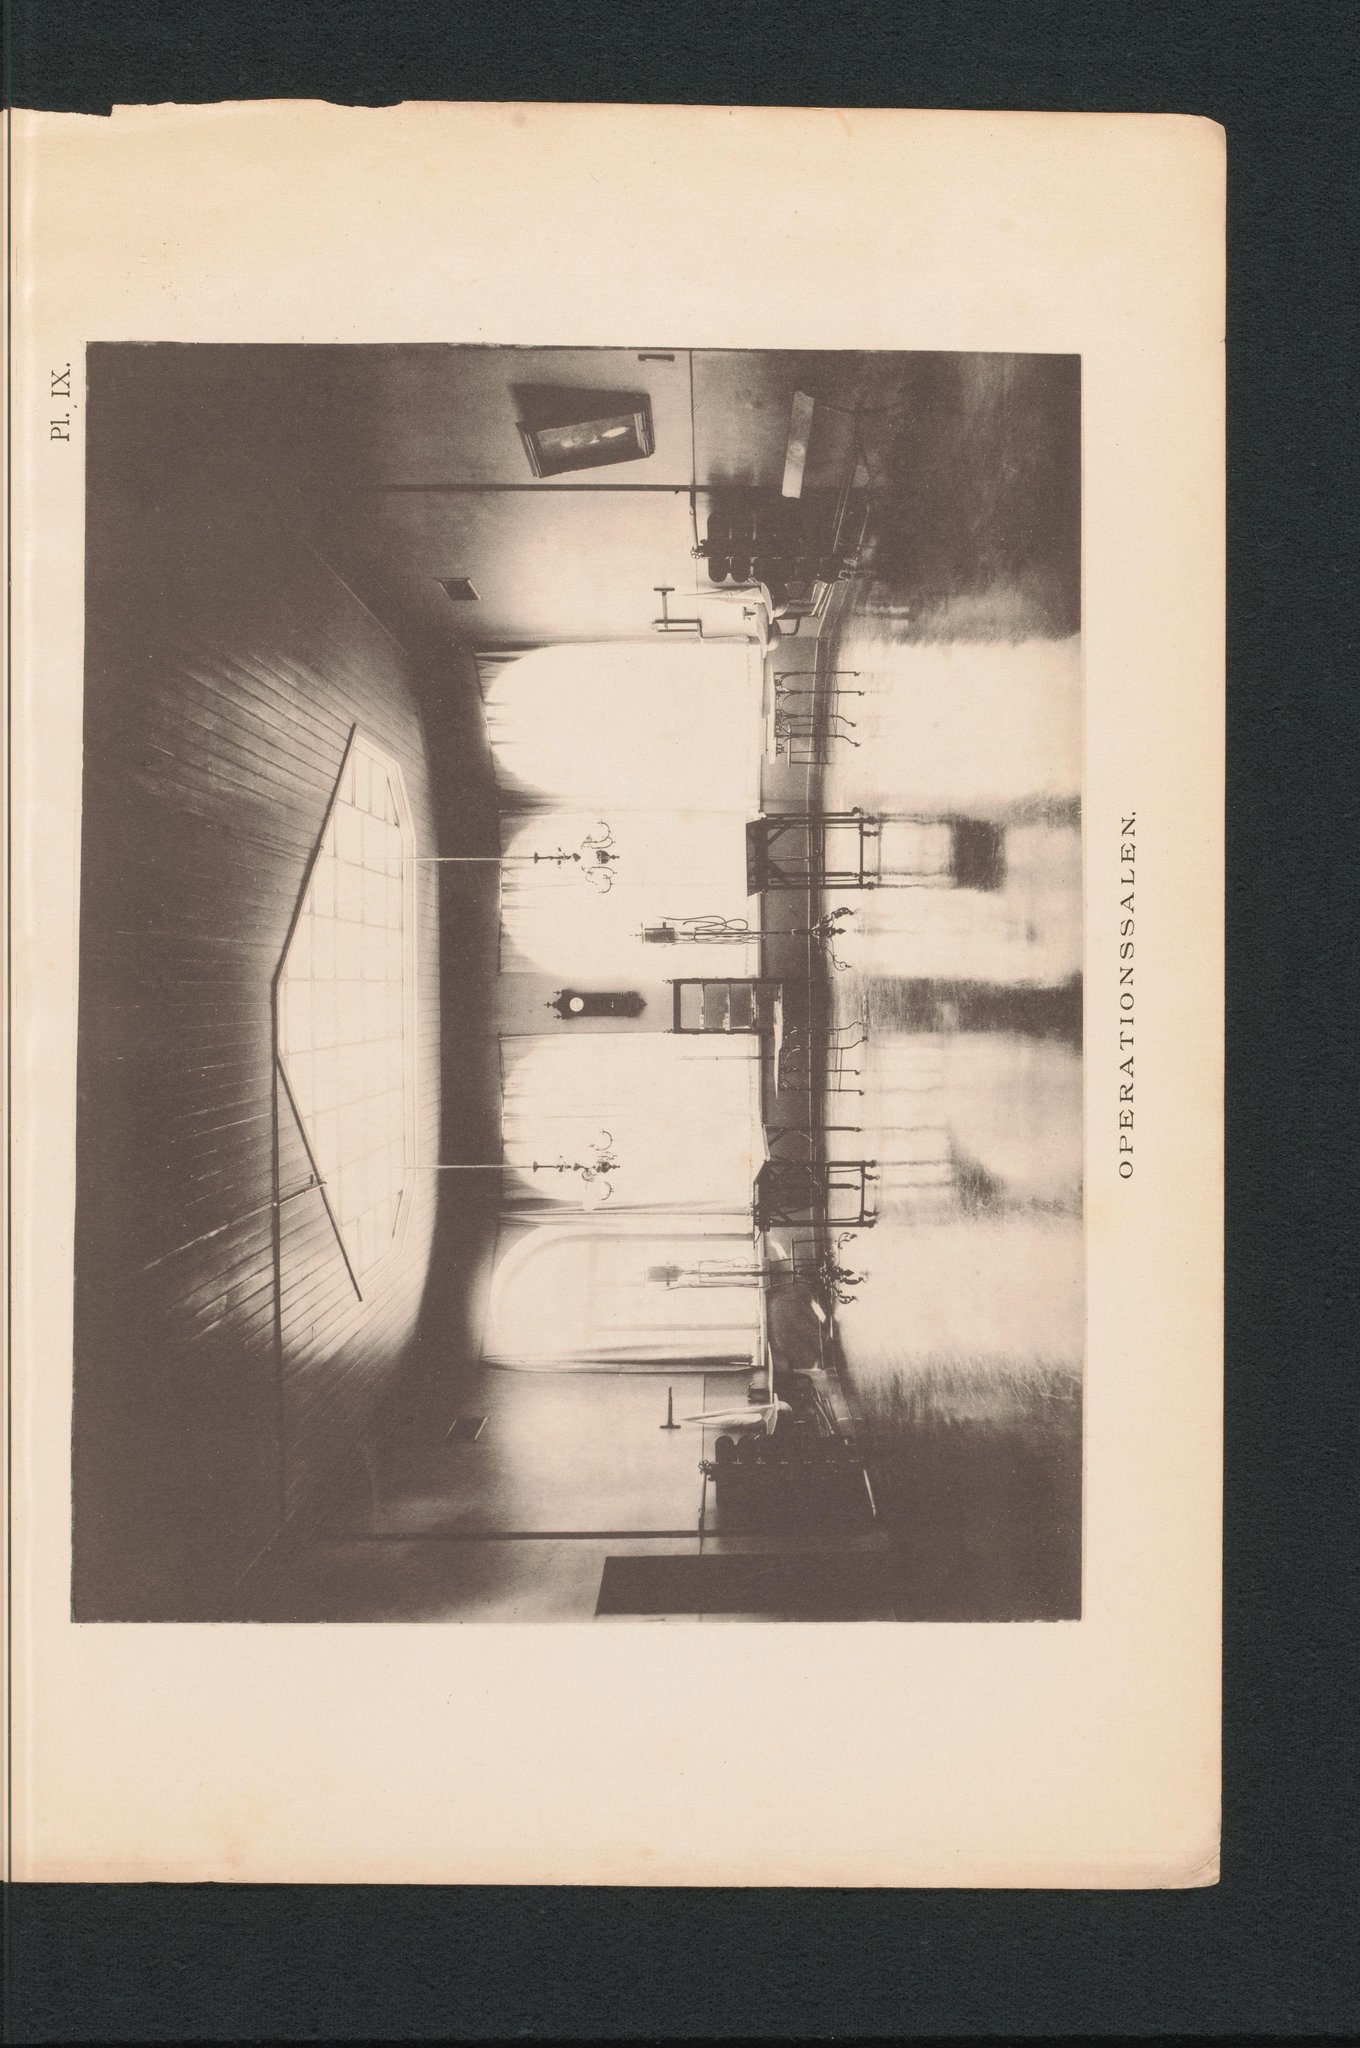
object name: photomechanical print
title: Operatiekamer in een chirurgisch ziekenhuis in Helsinki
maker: Anonymous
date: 1880-1890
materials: paper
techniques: photograph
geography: helsinki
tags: operating room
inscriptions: number: ‘Pl. IX.’